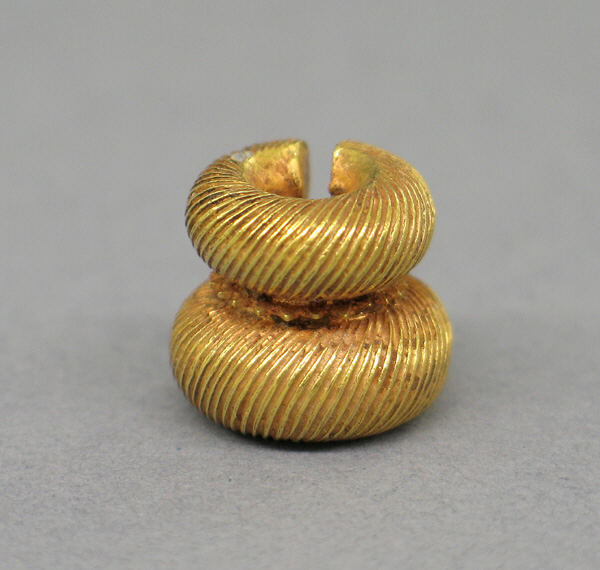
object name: fastener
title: Weighted Fastener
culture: indonesian, javanese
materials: gold